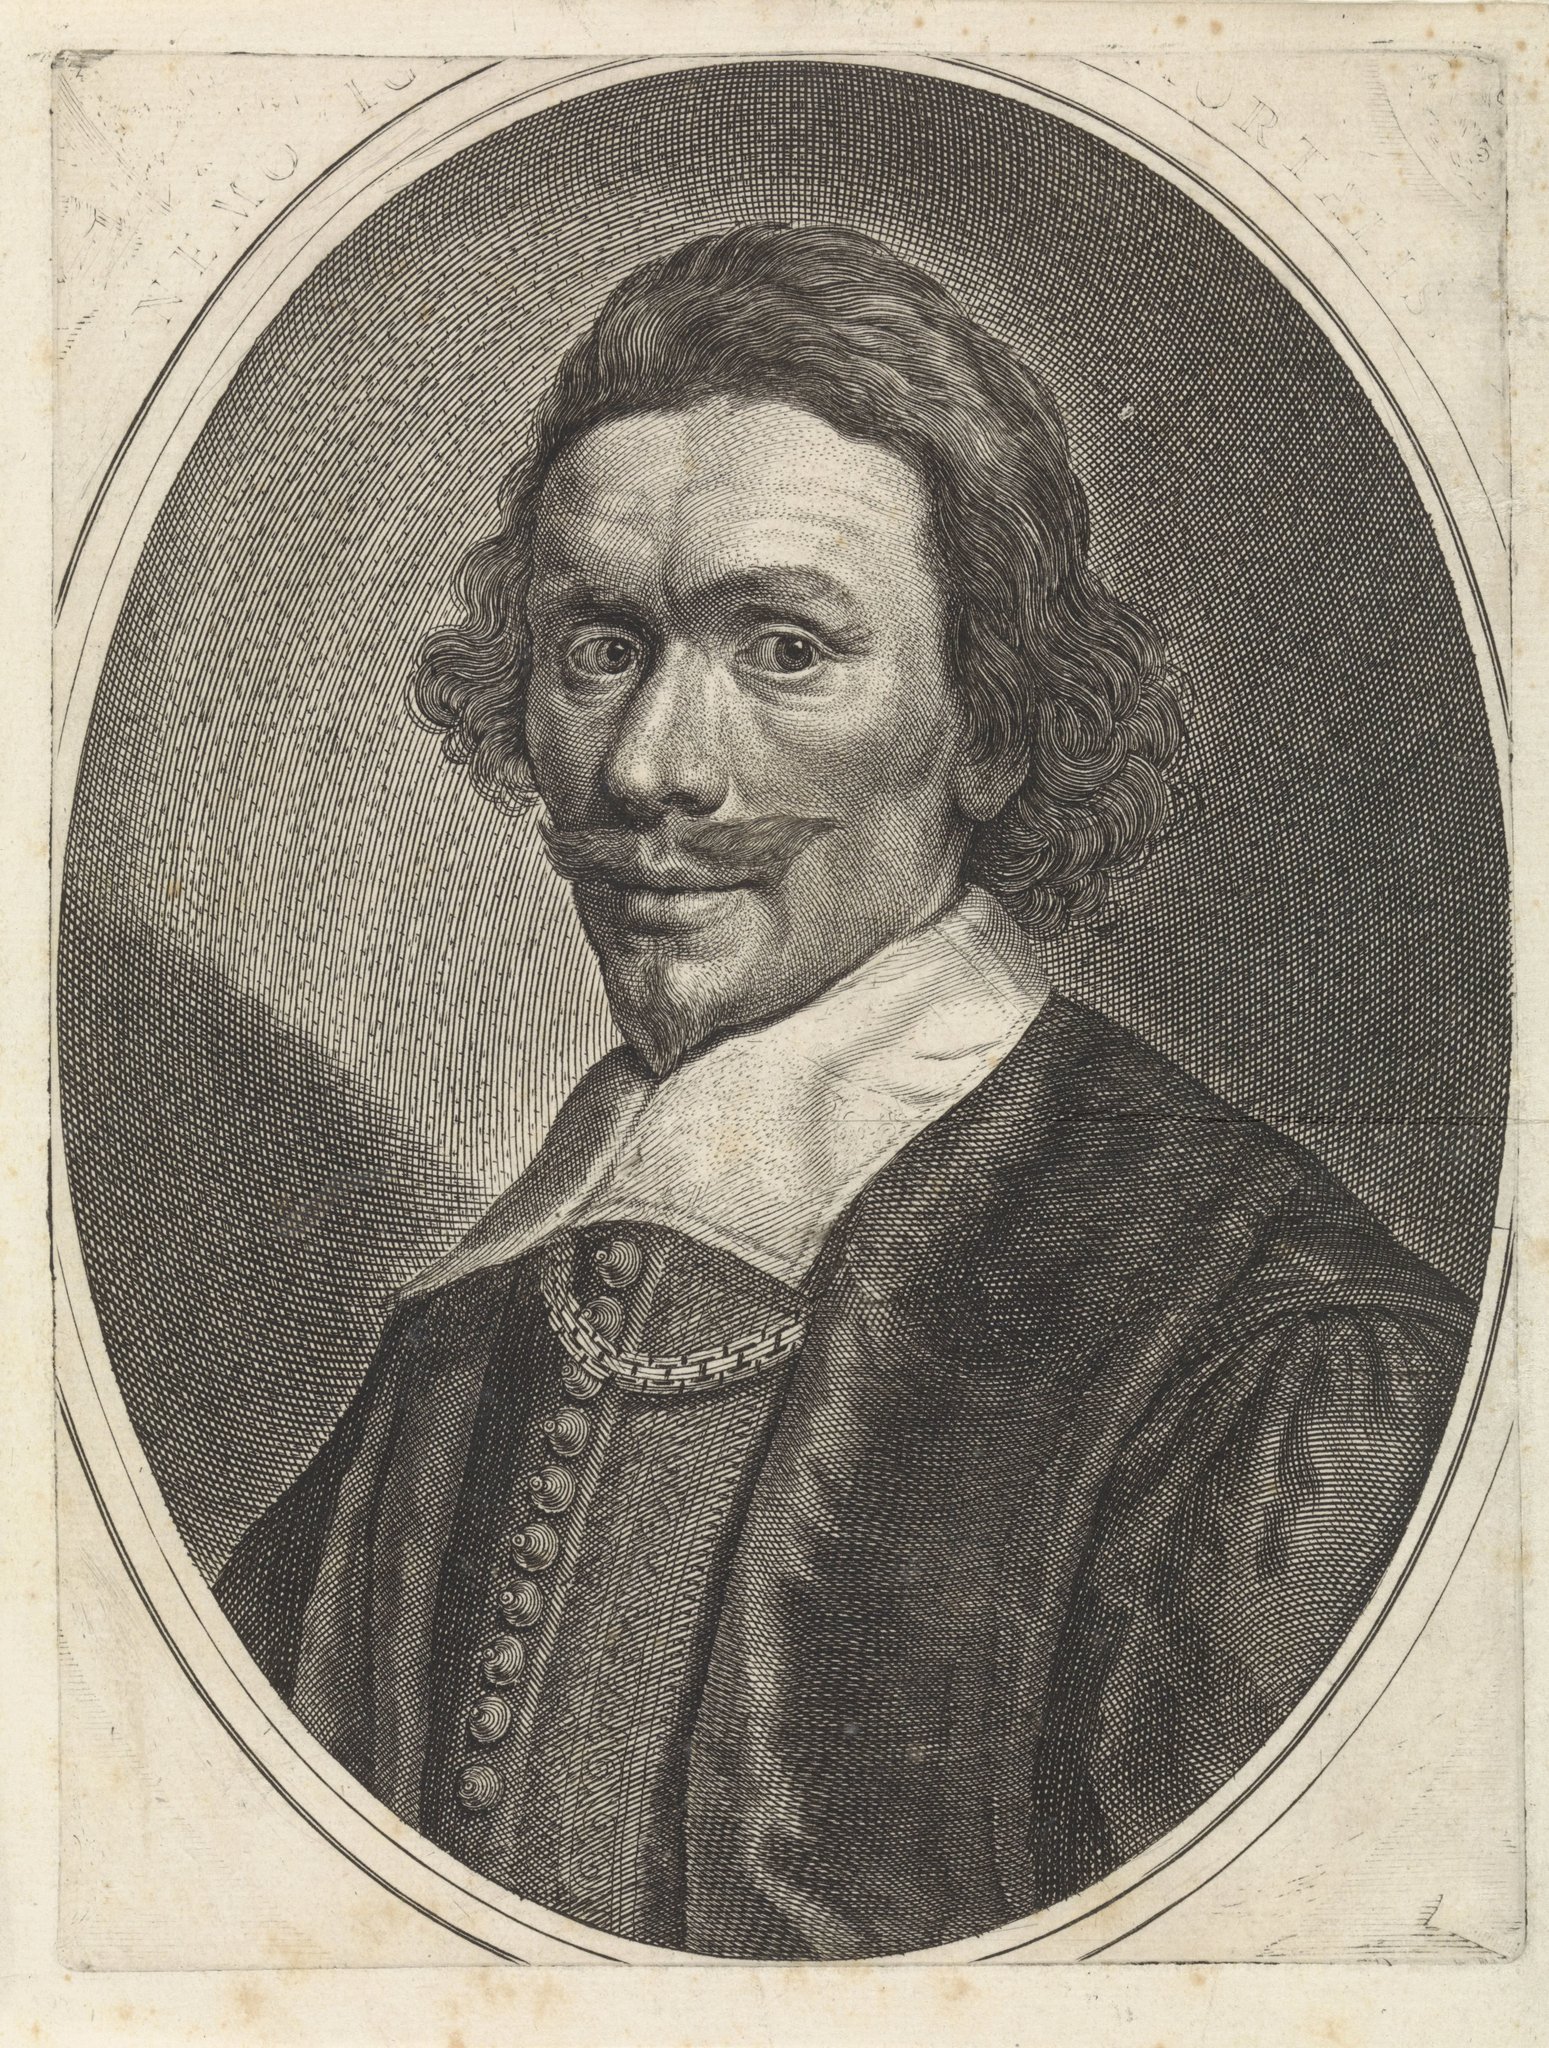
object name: print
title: Portret van Theodorus Johannes Dirk Graswinckel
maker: theodor matham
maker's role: draughtsman, print maker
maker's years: 1605-1676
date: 1636-1666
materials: paper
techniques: engraving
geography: northern netherlands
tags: mechelen, theodorus johannes dirk graswinckel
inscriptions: collector's mark: Lugt 2228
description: Portret van Theodorus Johannes Dirk Graswinckel, advocaat-fiscaal van Holland, jurist en humanist. Tevens van hij dichter en bevriend met P.C. Hooft. Rond het portret symbolen van een goede rechtspraak (caduceus van Mercurius, balans en zwaard van Justitia en wapenrusting van Minerva) en van de dichtkunst (harp en lier).